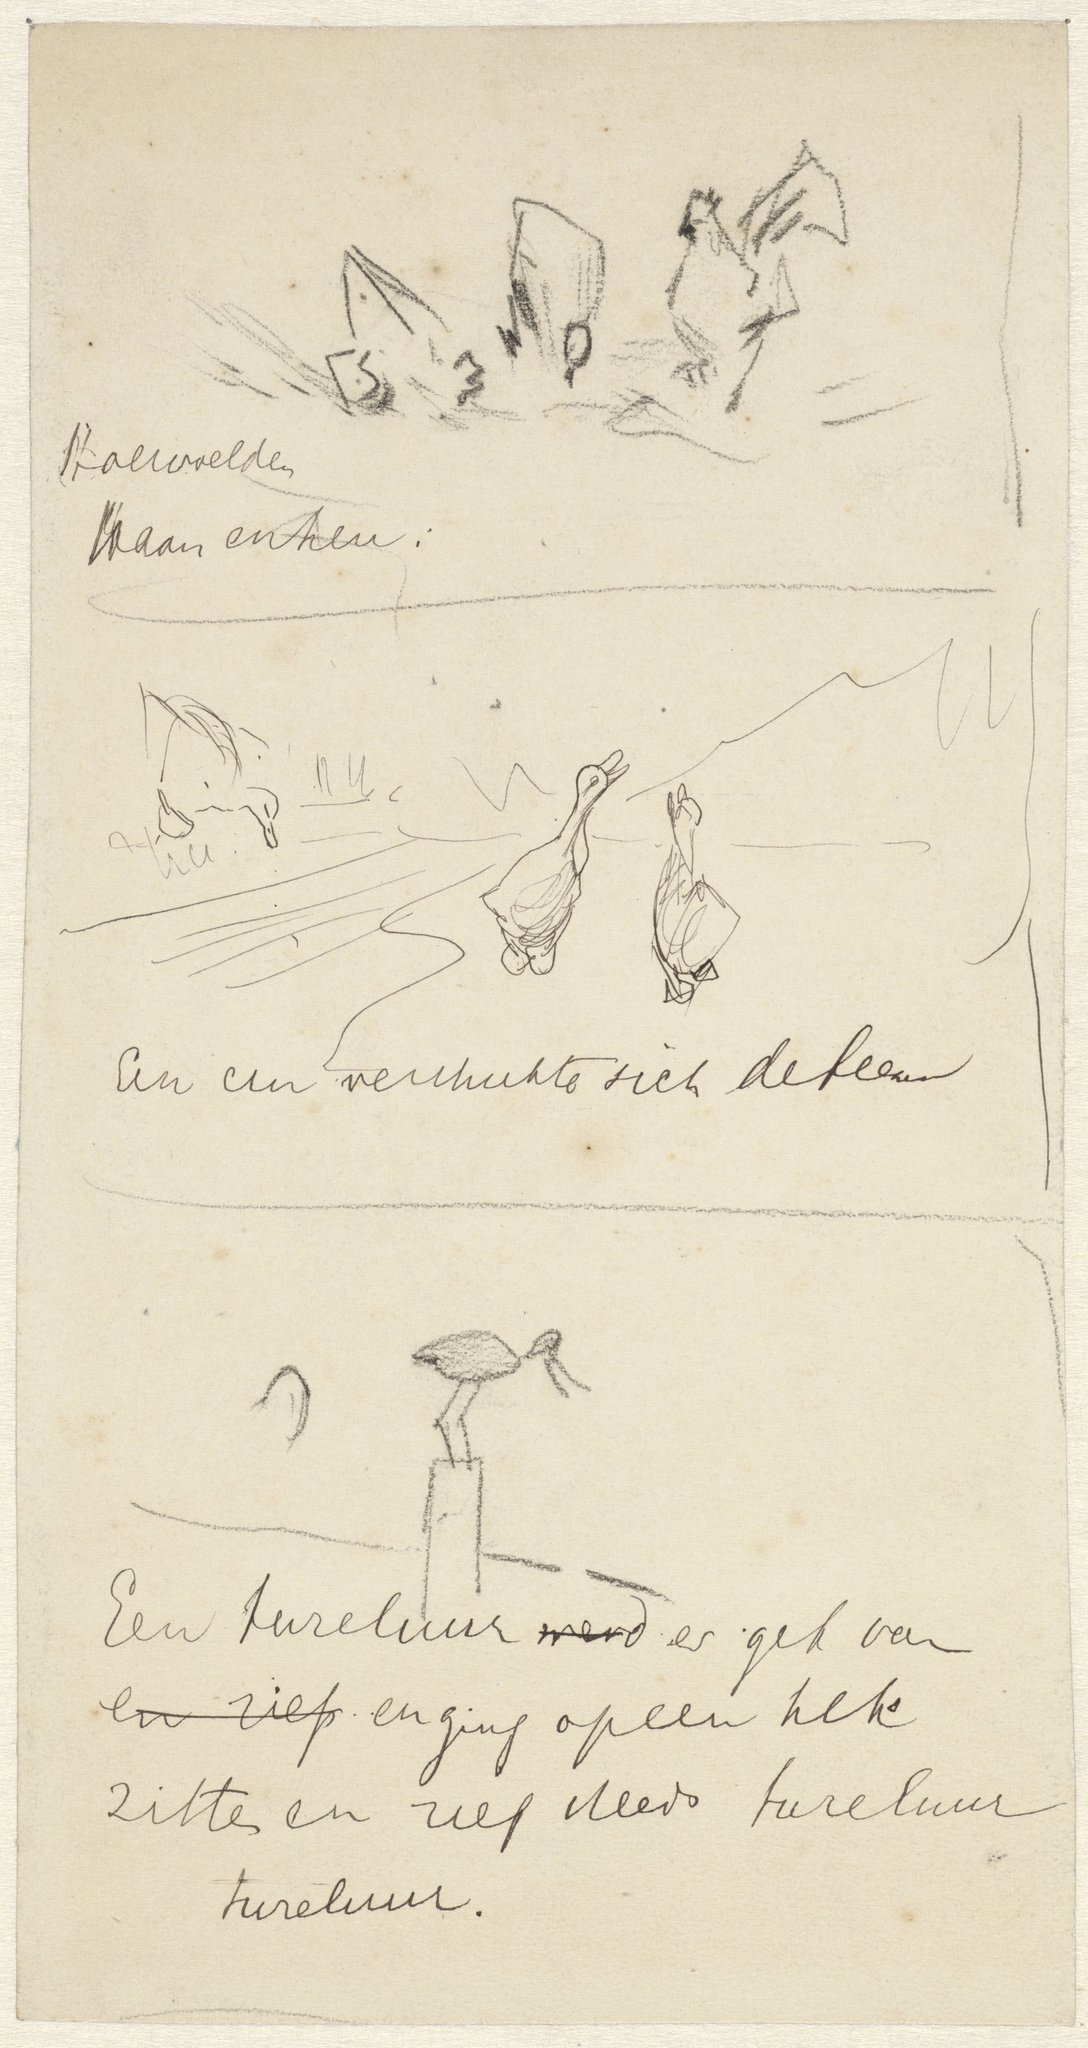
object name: drawing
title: Drie schetsen voor illustraties in Hoe de vogels aan een koning kwamen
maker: theo van hoytema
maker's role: draughtsman, painter, print maker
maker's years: 1863-1917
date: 1873-1917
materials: chalk, ink, paper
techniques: pen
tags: birds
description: Voorstudie voor prent in 'Hoe de vogels aan een koning kwamen'.